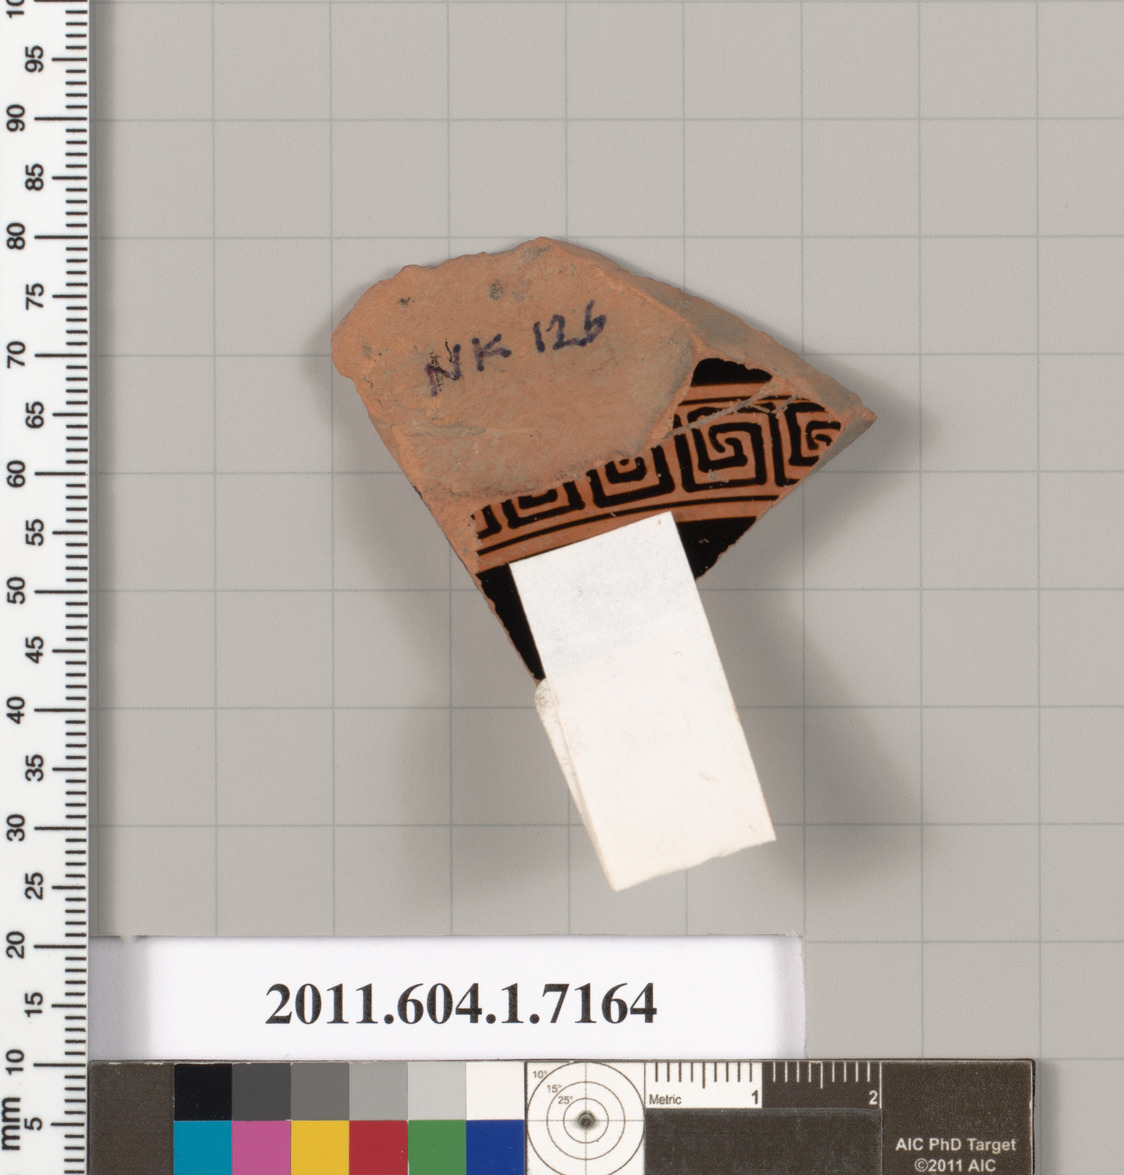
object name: kylix fragment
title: Terracotta fragment of a kylix (drinking cup)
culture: greek, attic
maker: makron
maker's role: artist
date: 500-480 BCE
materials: terracotta